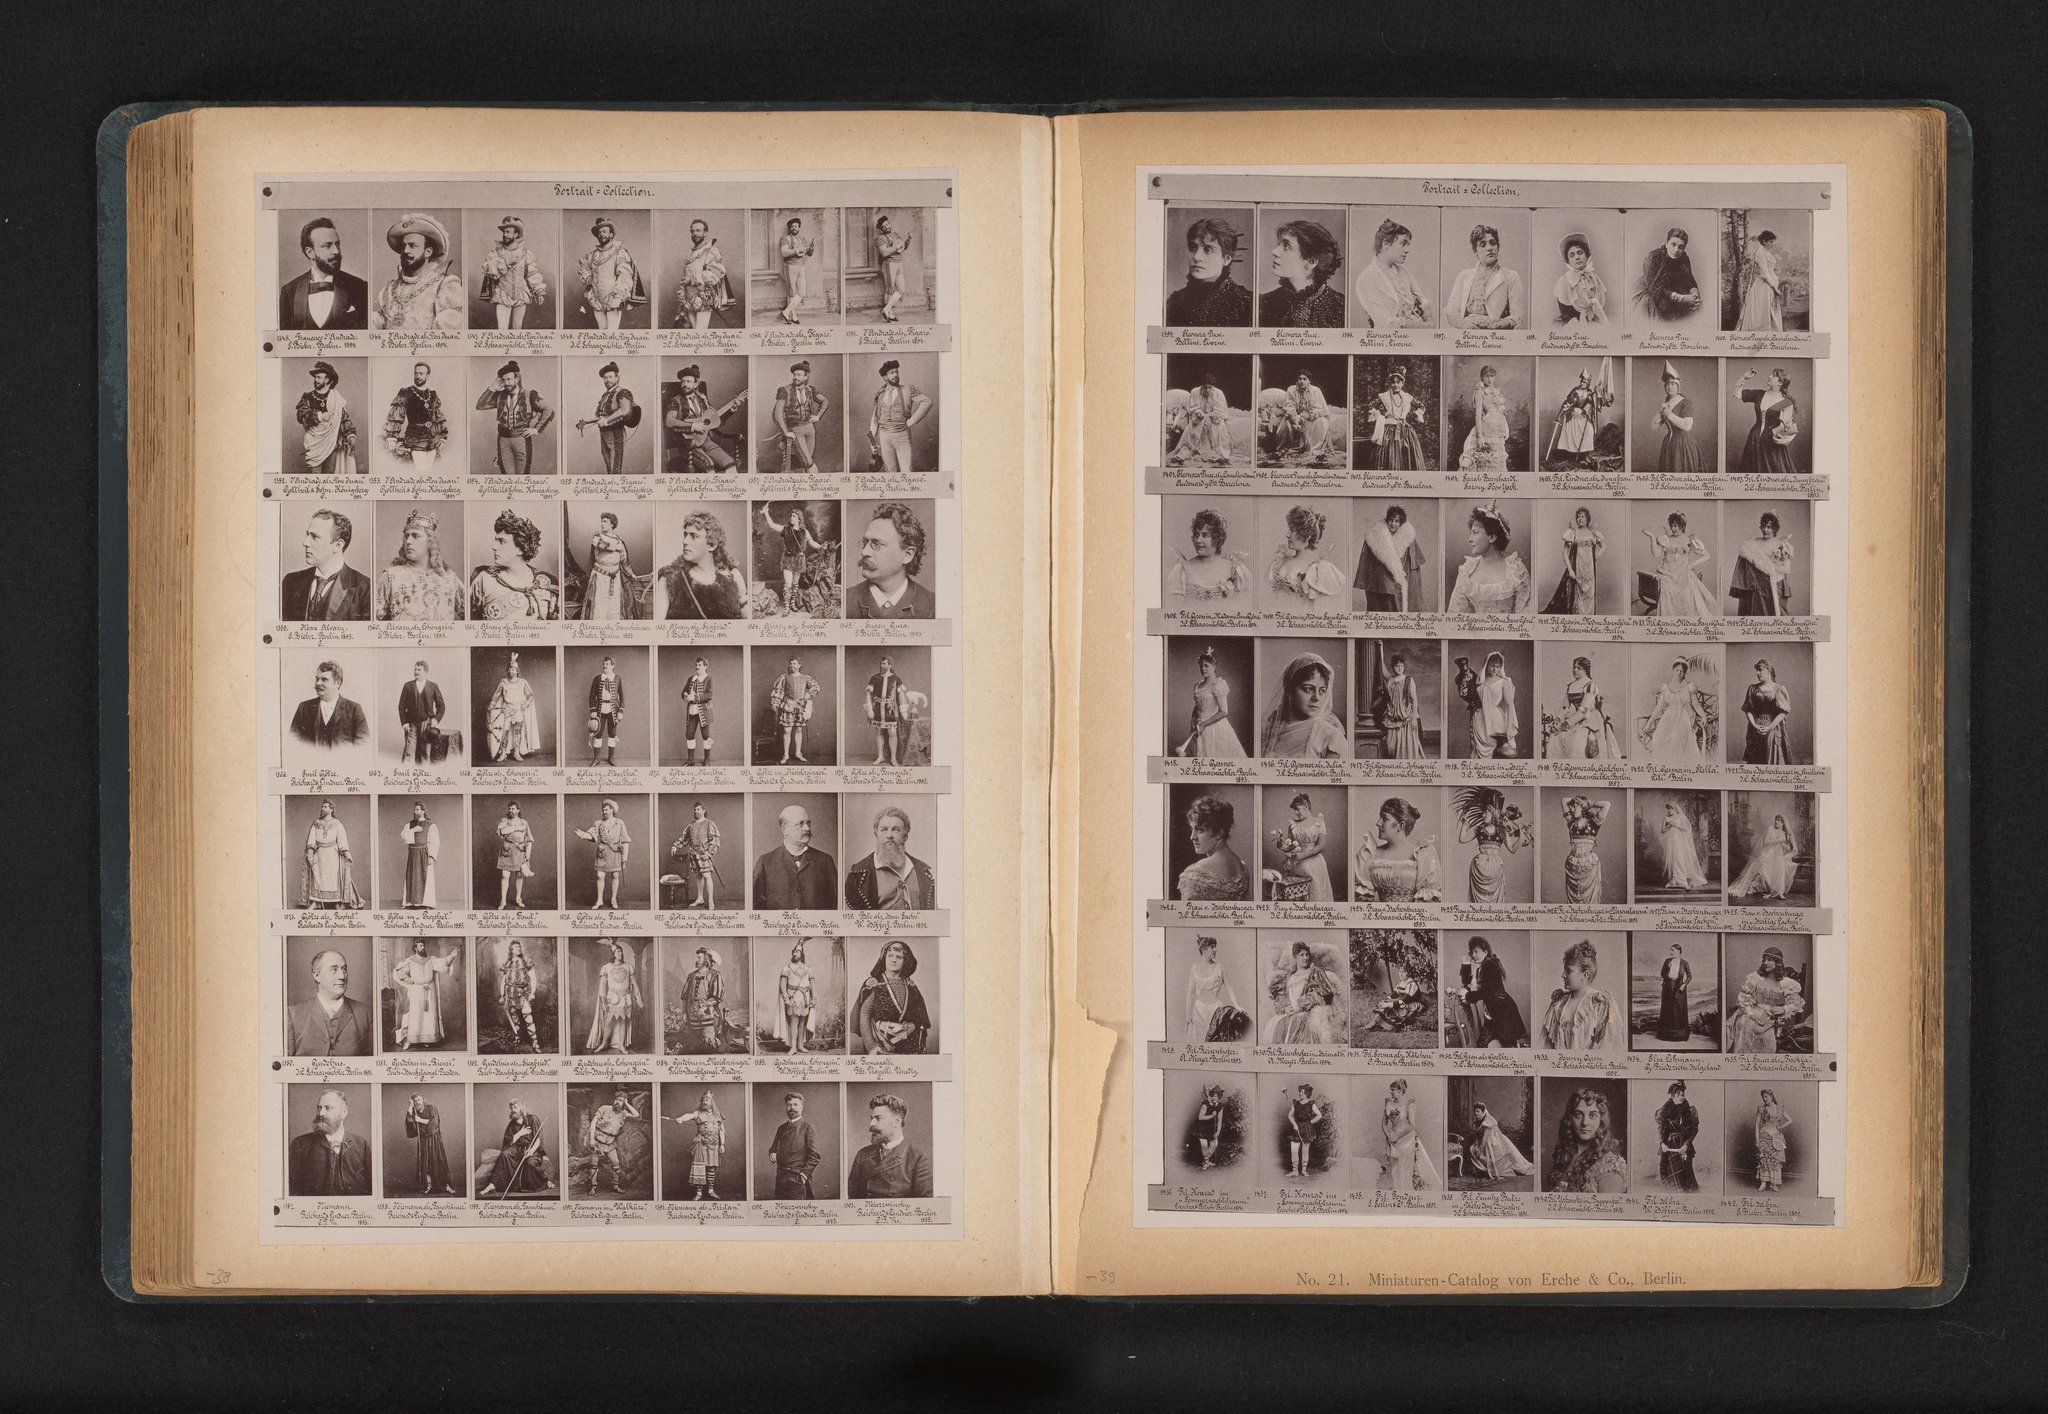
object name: page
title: Portretten van Duitse acteurs en actrices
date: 1880-1885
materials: paper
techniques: photograph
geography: berlin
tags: portrait of actor, actress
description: Prent op achtendertigste ongenummerde pagina.